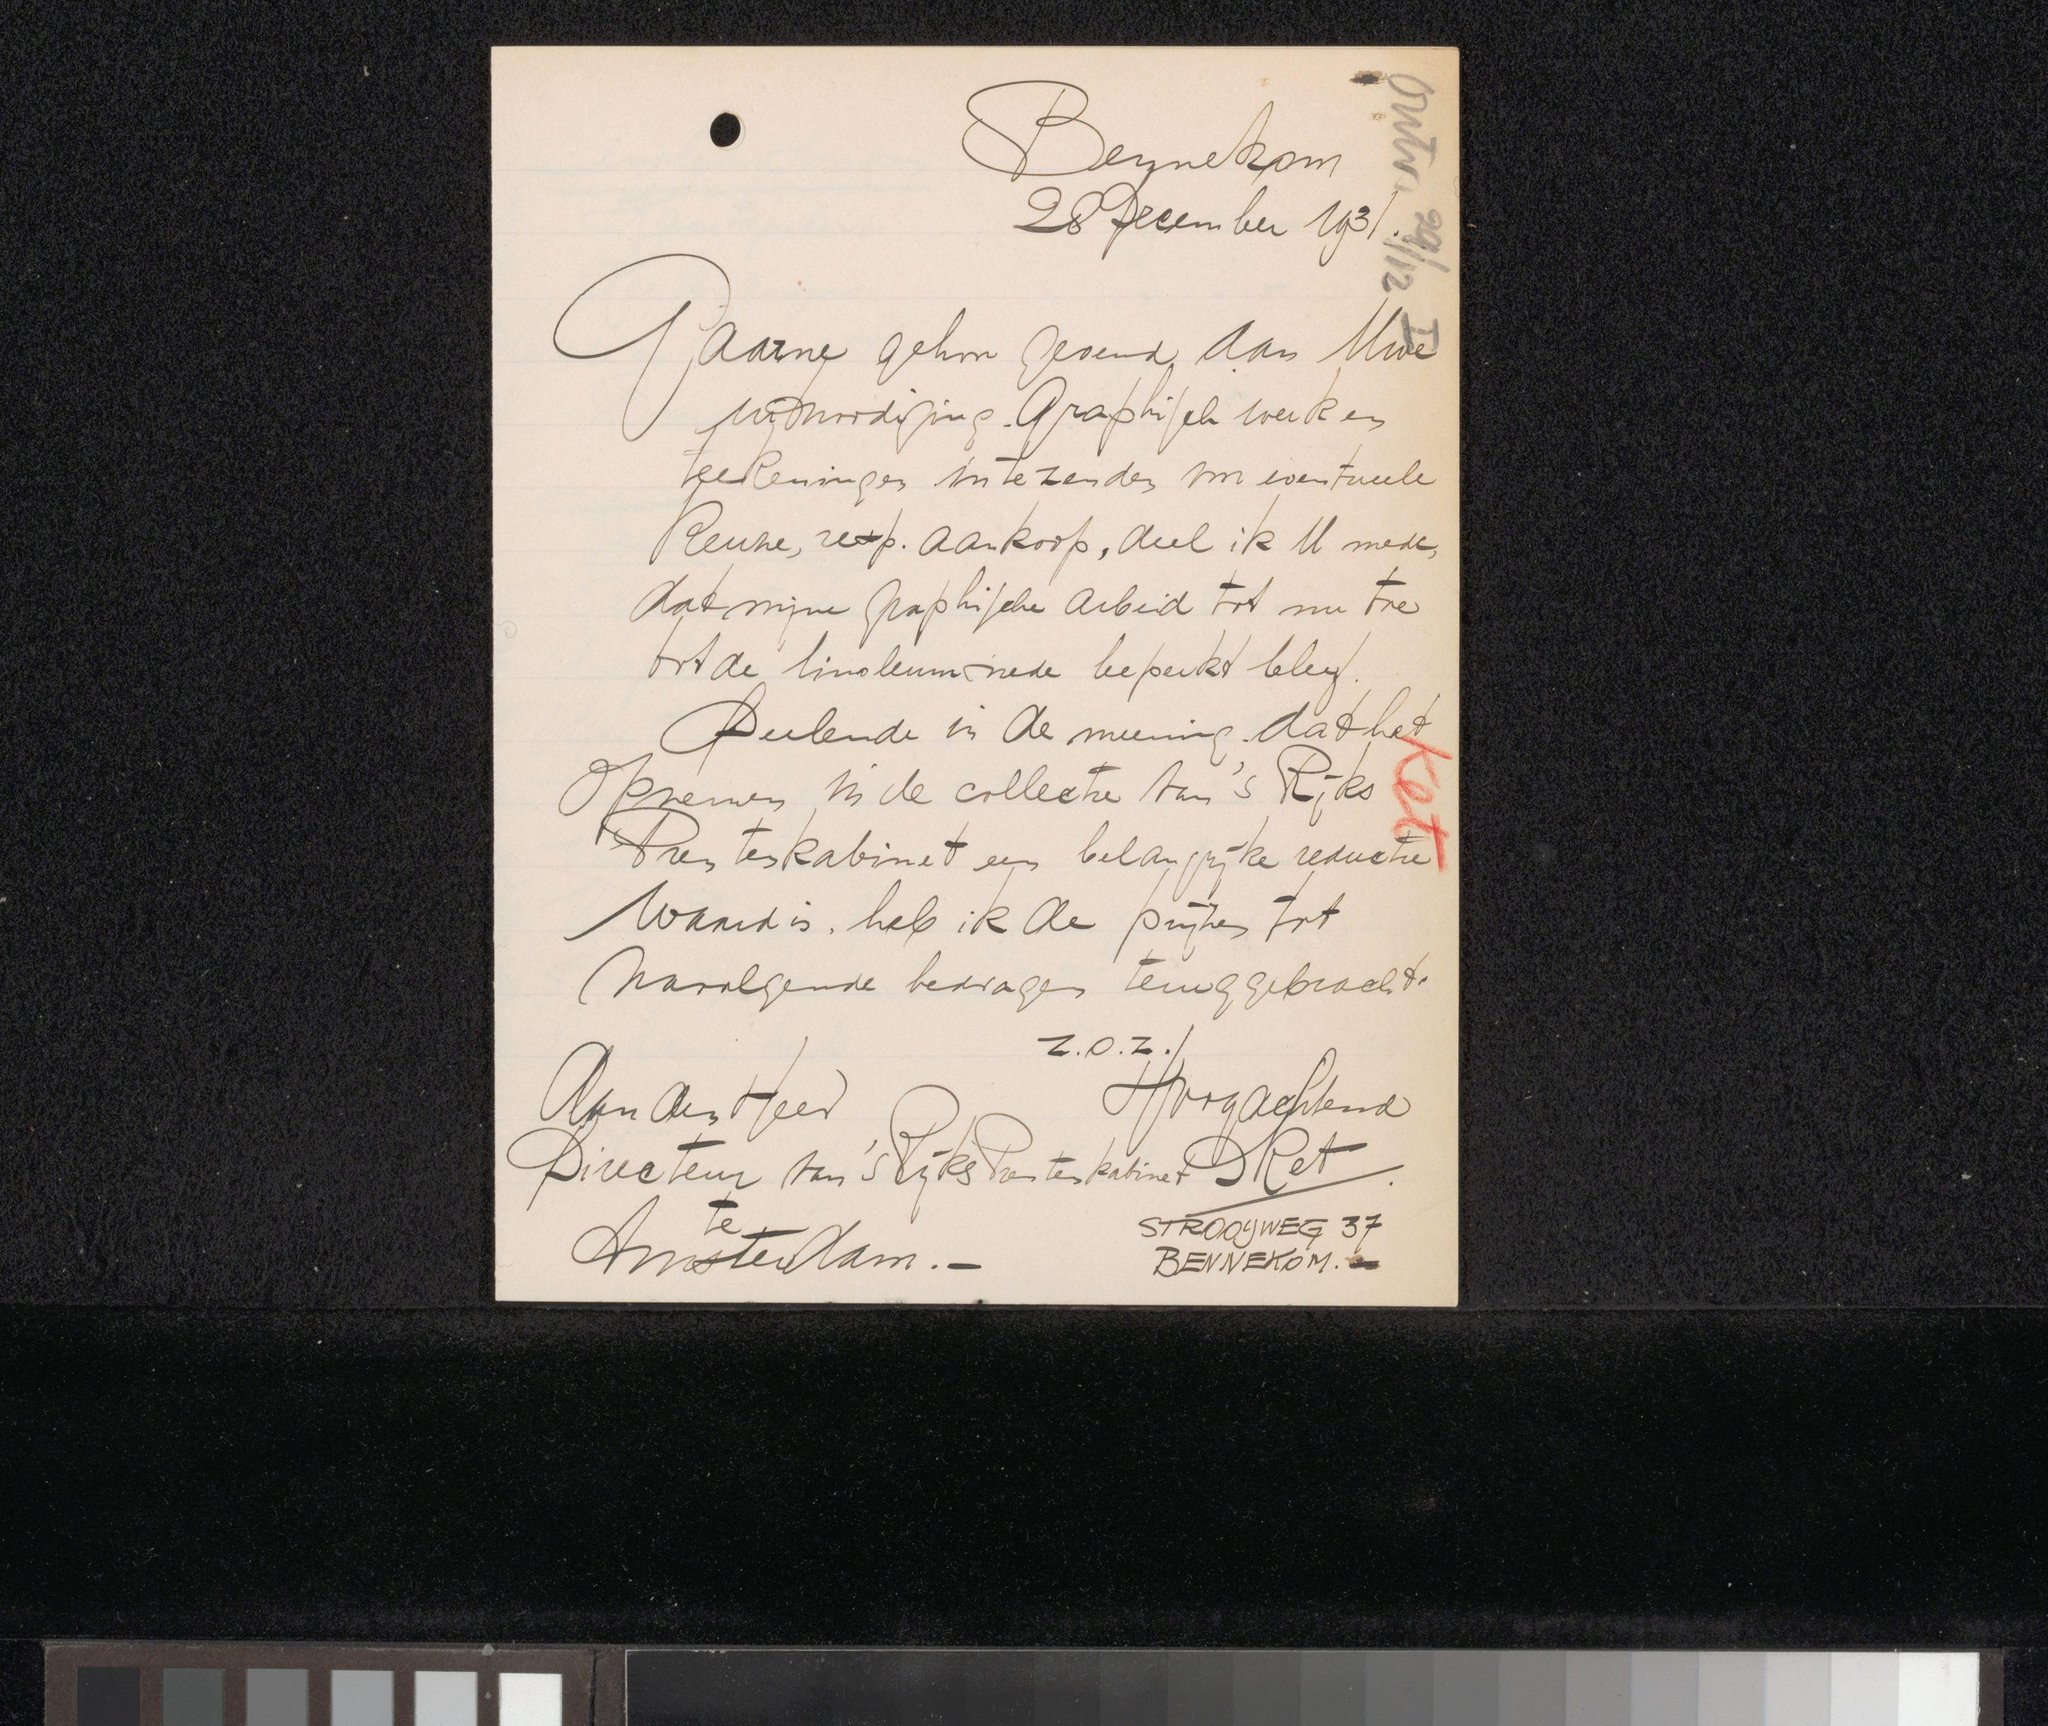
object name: letter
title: Brief aan jonkheer Hendrik Teding van Berkhout (1879-1969)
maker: dick ket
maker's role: draughtsman, print maker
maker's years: 1902-1940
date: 1931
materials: ink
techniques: pen, writing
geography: bennekom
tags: haarlem, jonkheer hendrik teding van berkhout (1879-1969), drawing, the graphic arts, art collecting, money